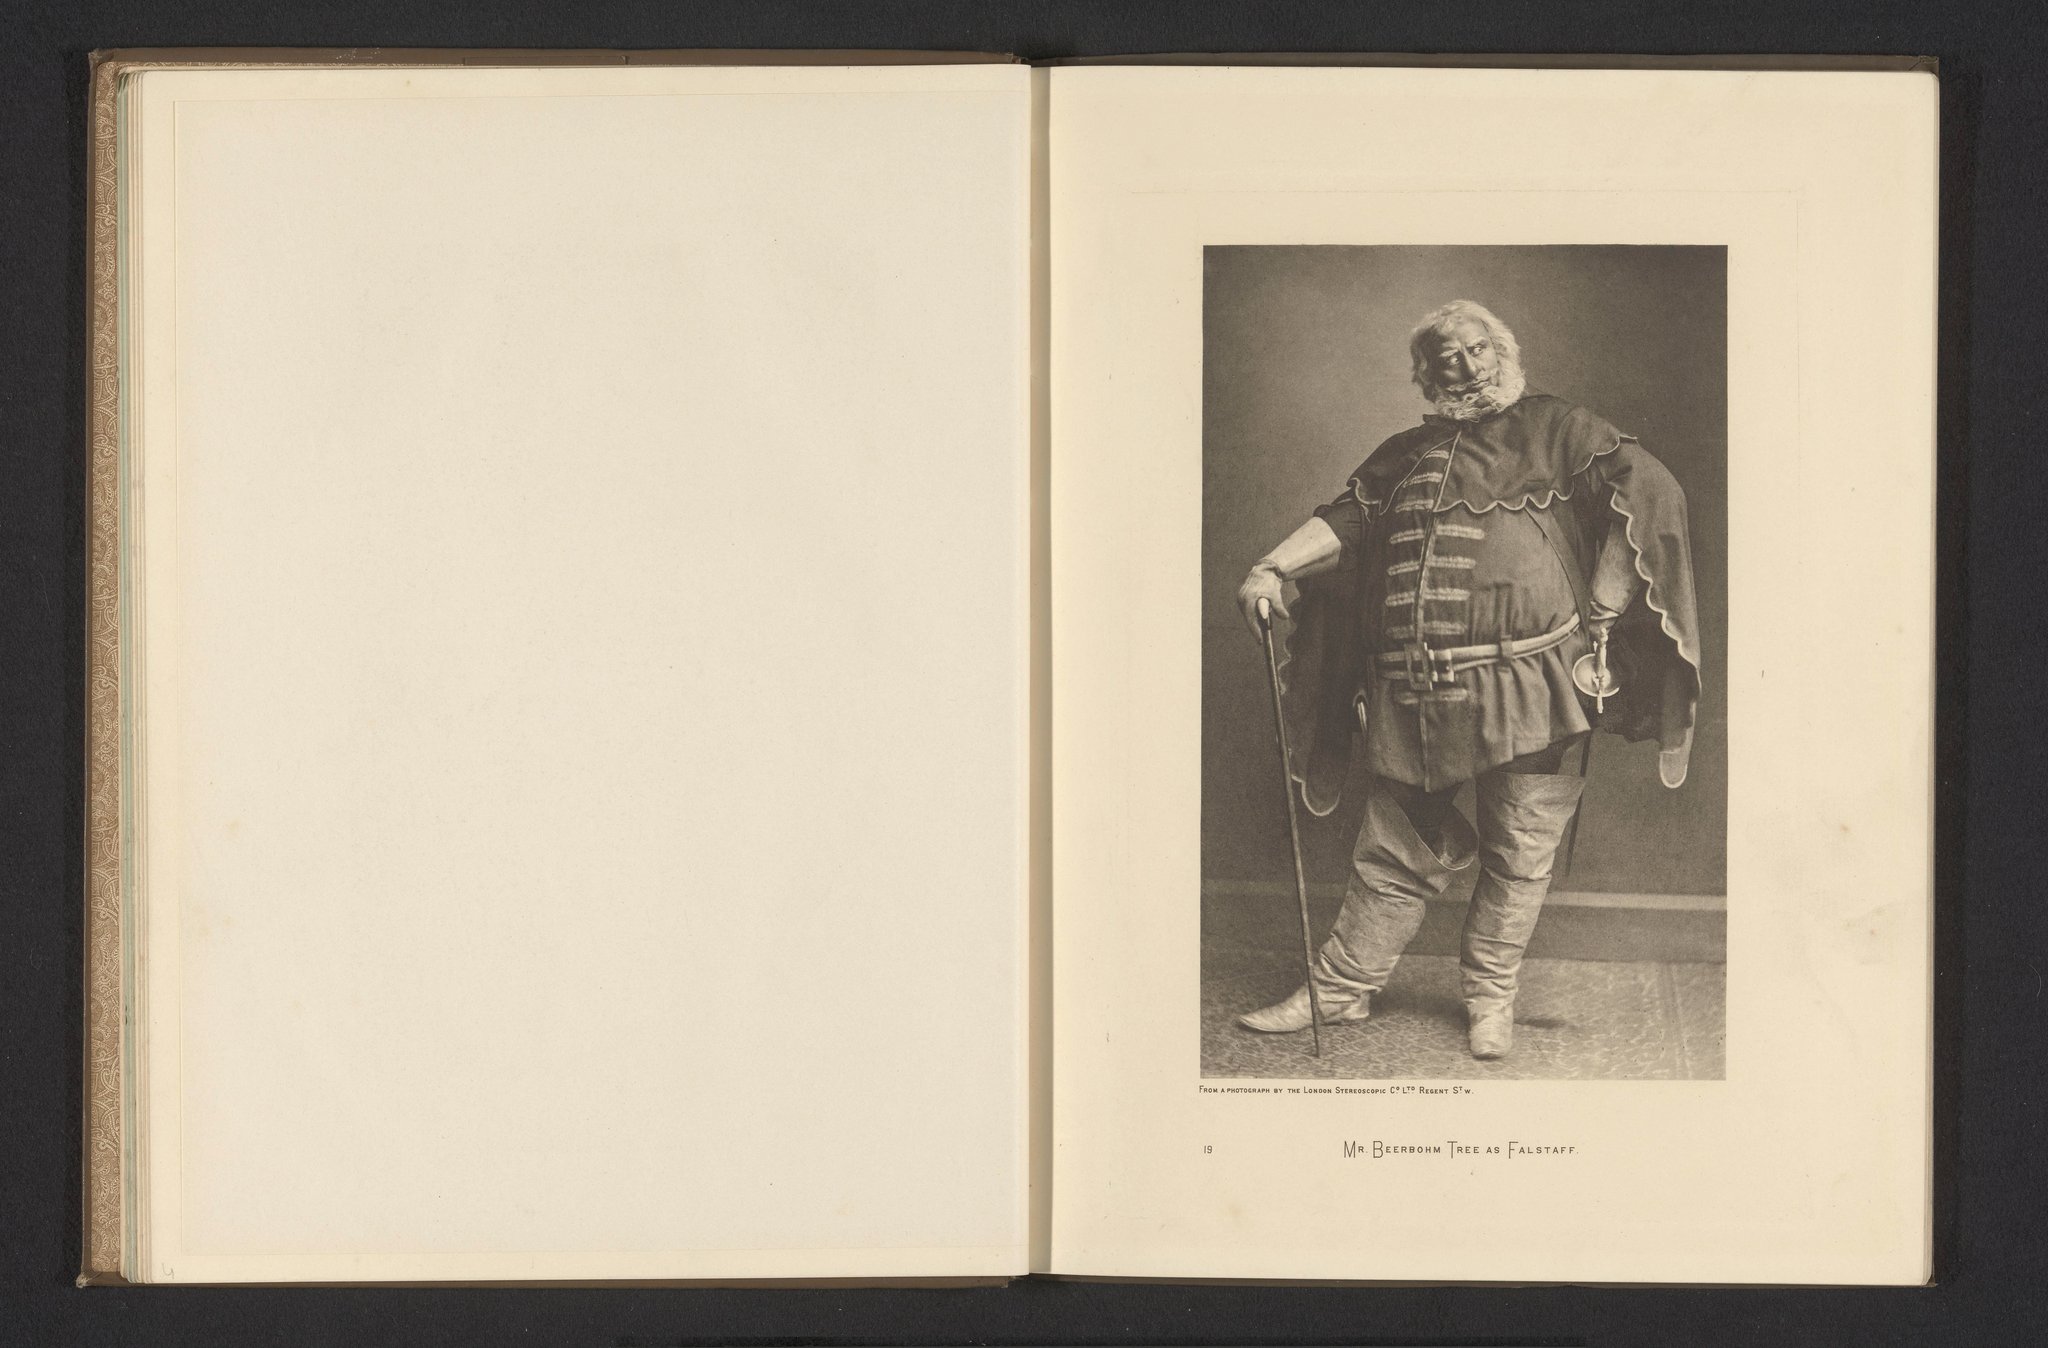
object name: page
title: Herbert Beerbohm Tree as Falstaff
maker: Anonymous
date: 1883-1893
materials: paper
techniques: photoaquatint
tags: portrait of actor, actress